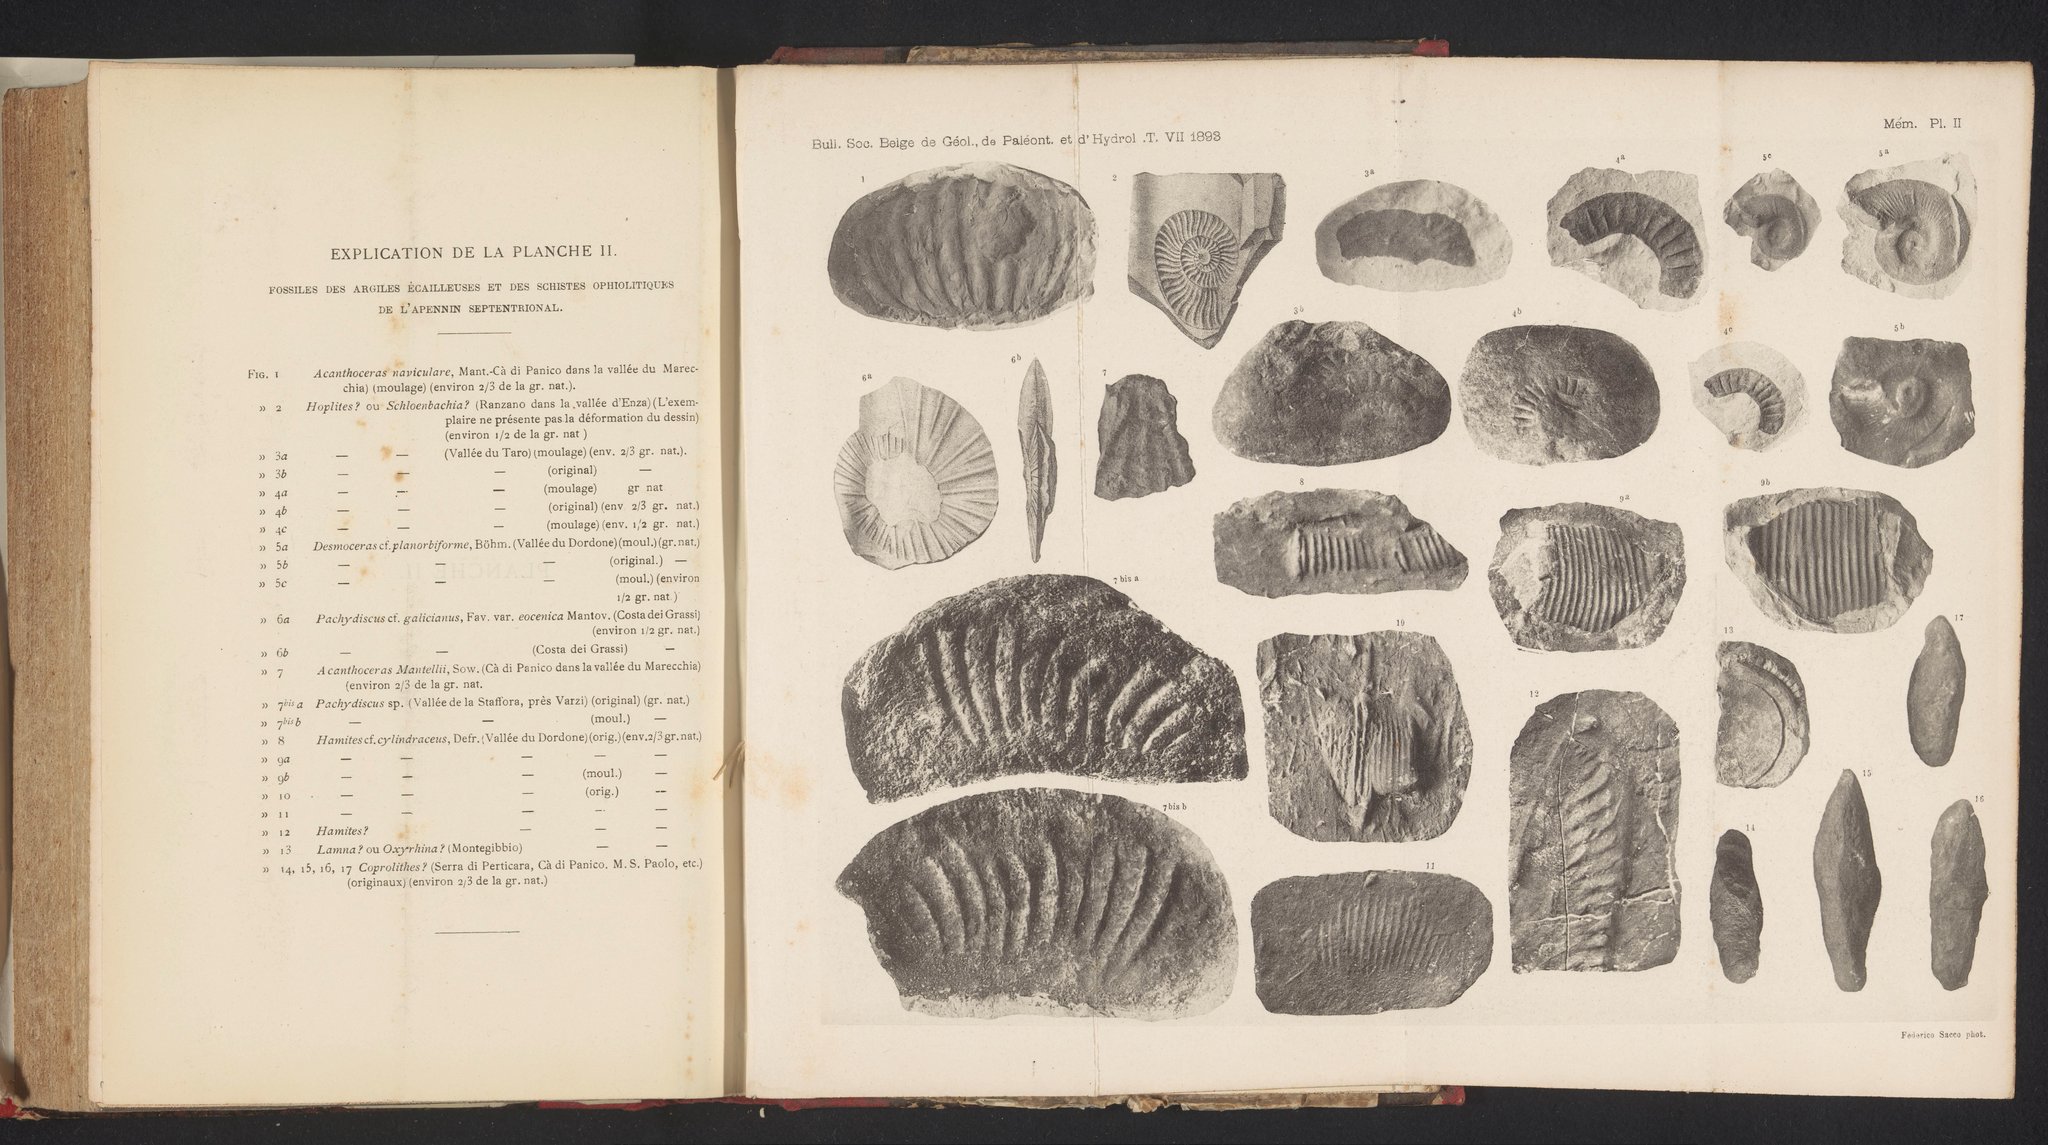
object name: photomechanical print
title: Verzameling van verschillende fossielen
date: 1888-1893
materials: paper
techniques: autotype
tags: fossil plants, fossil animals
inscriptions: inscription: ‘Bull. So. Belge de Géol., de Paléont. et d'Hydrol .T. VII 1893./ Mém Pl. II’